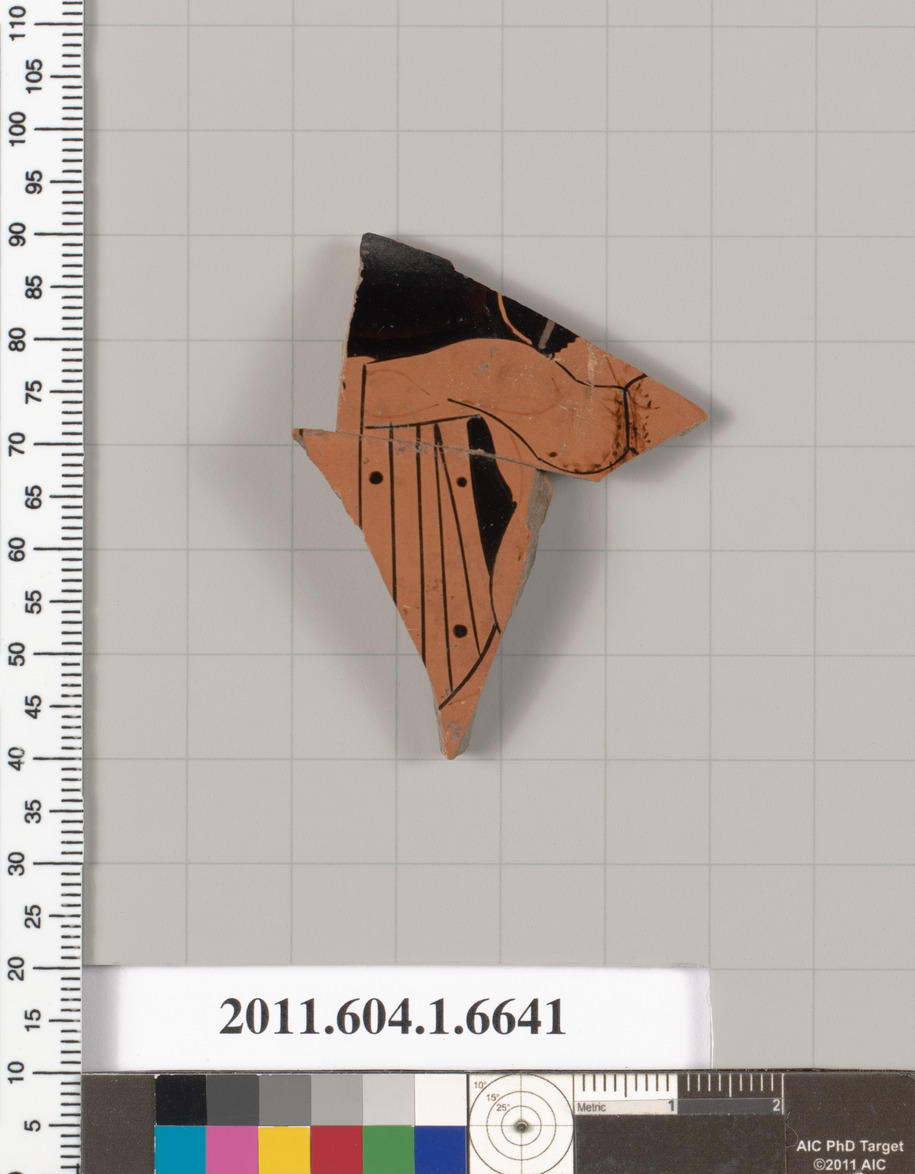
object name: kylix fragment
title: Terracotta fragment of a kylix (drinking cup)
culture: greek, attic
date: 490-470 BCE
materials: terracotta